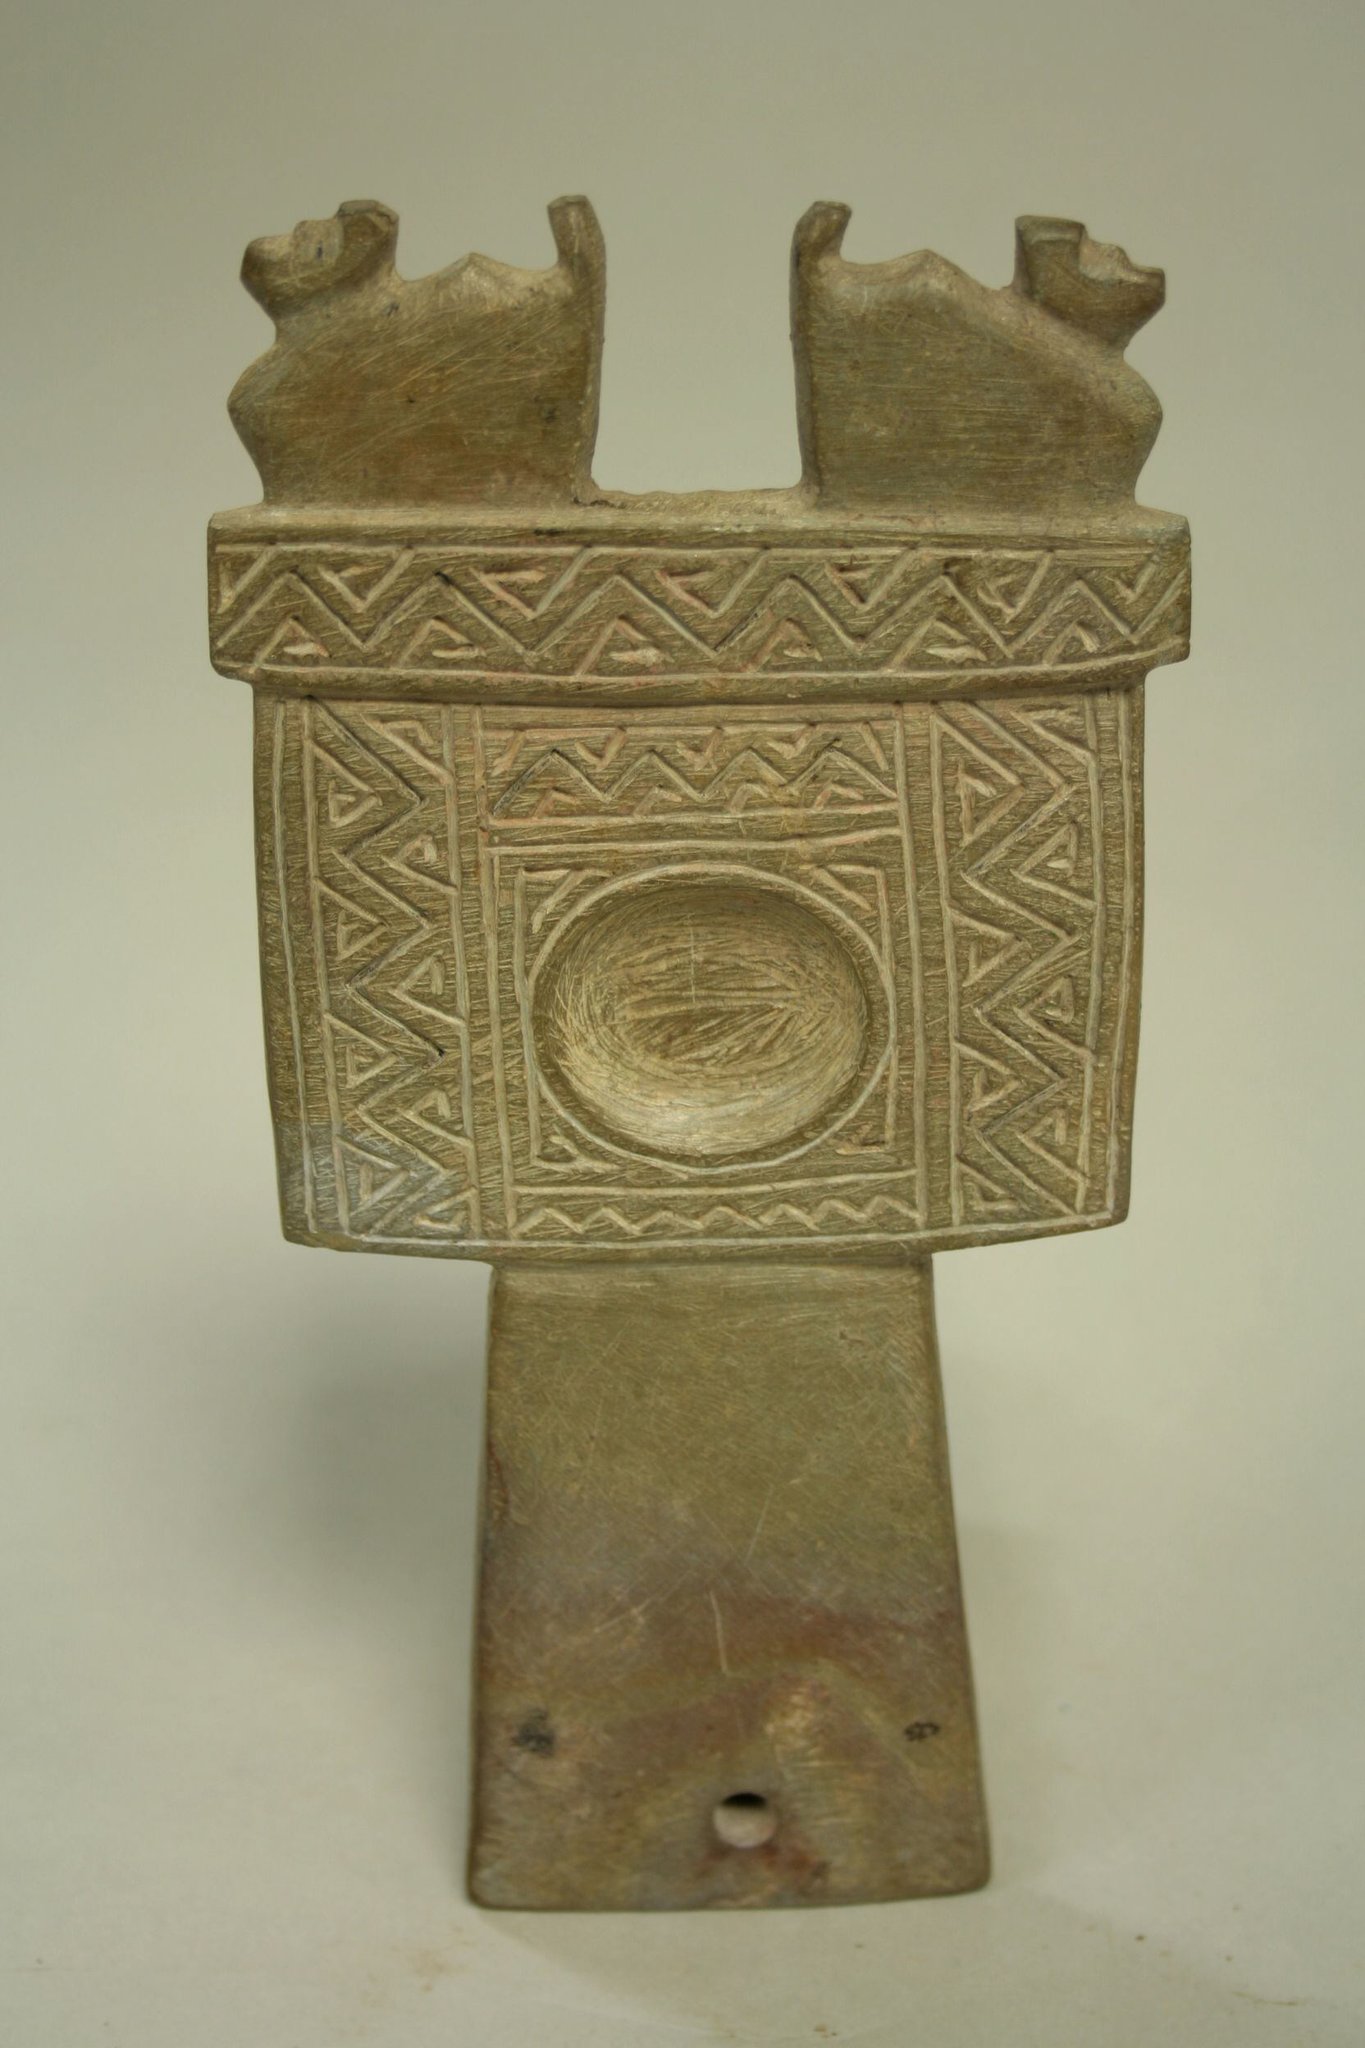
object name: mirror frame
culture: chimú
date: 901-1500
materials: stone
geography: peru